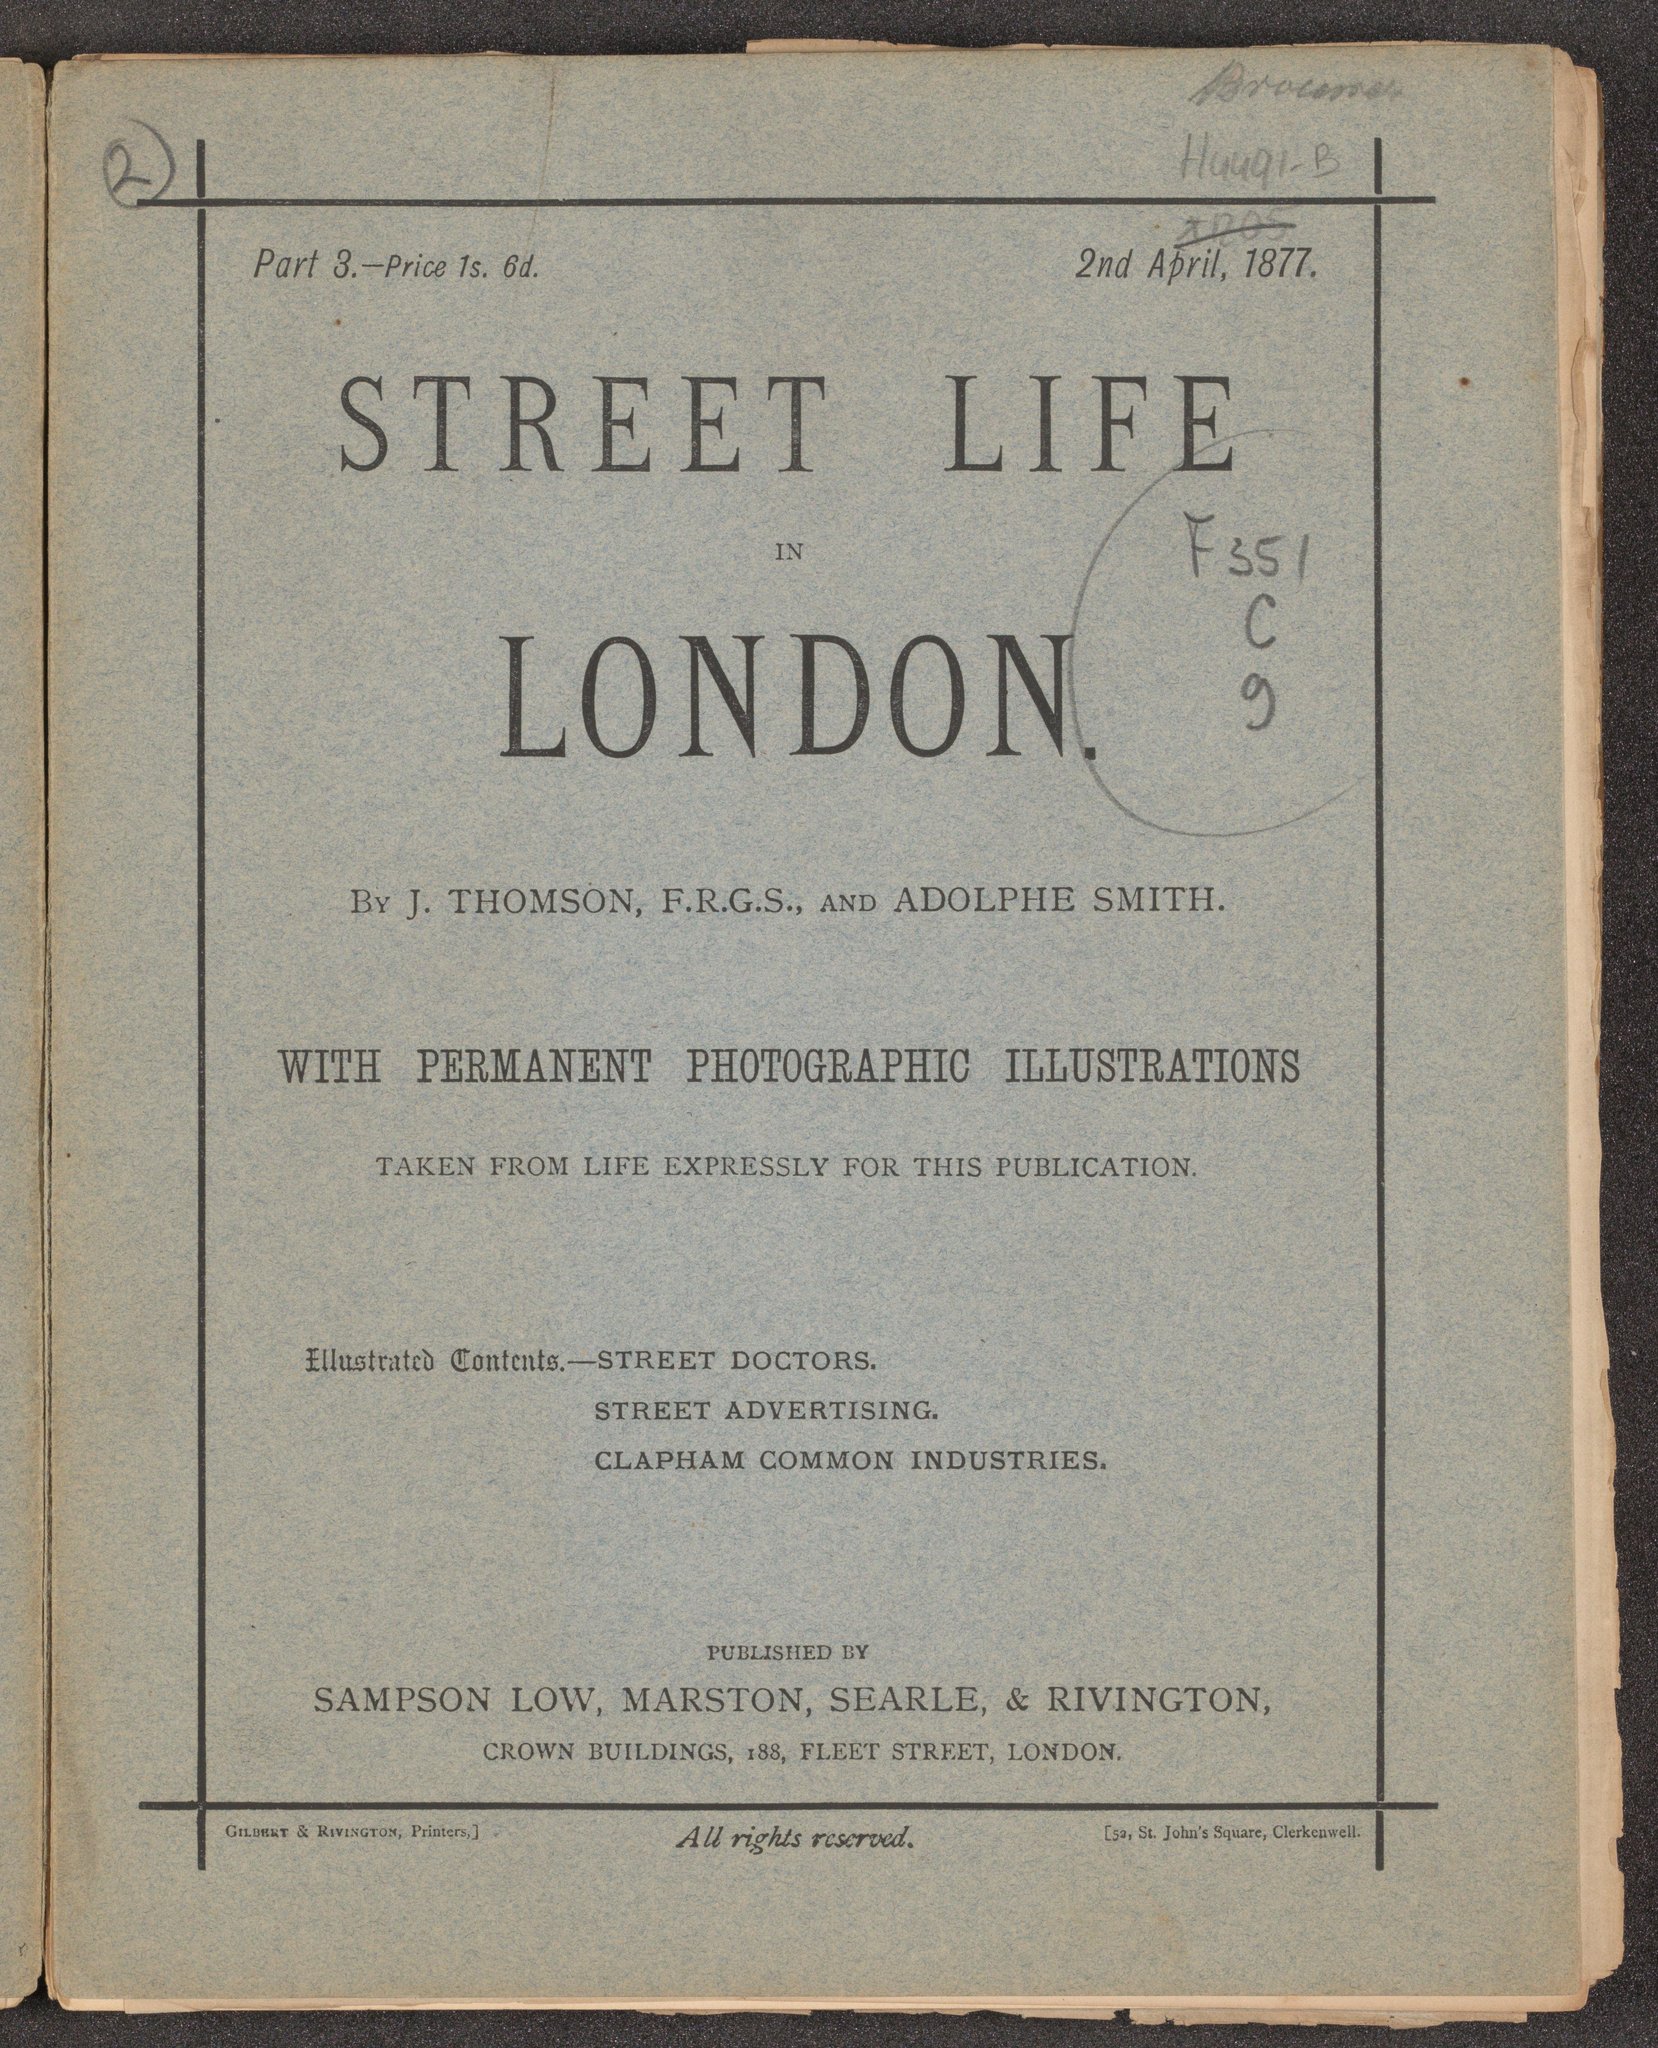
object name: page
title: Street Life in London, Part 3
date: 1804-1877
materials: paper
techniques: etching, printing, woodburytype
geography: london